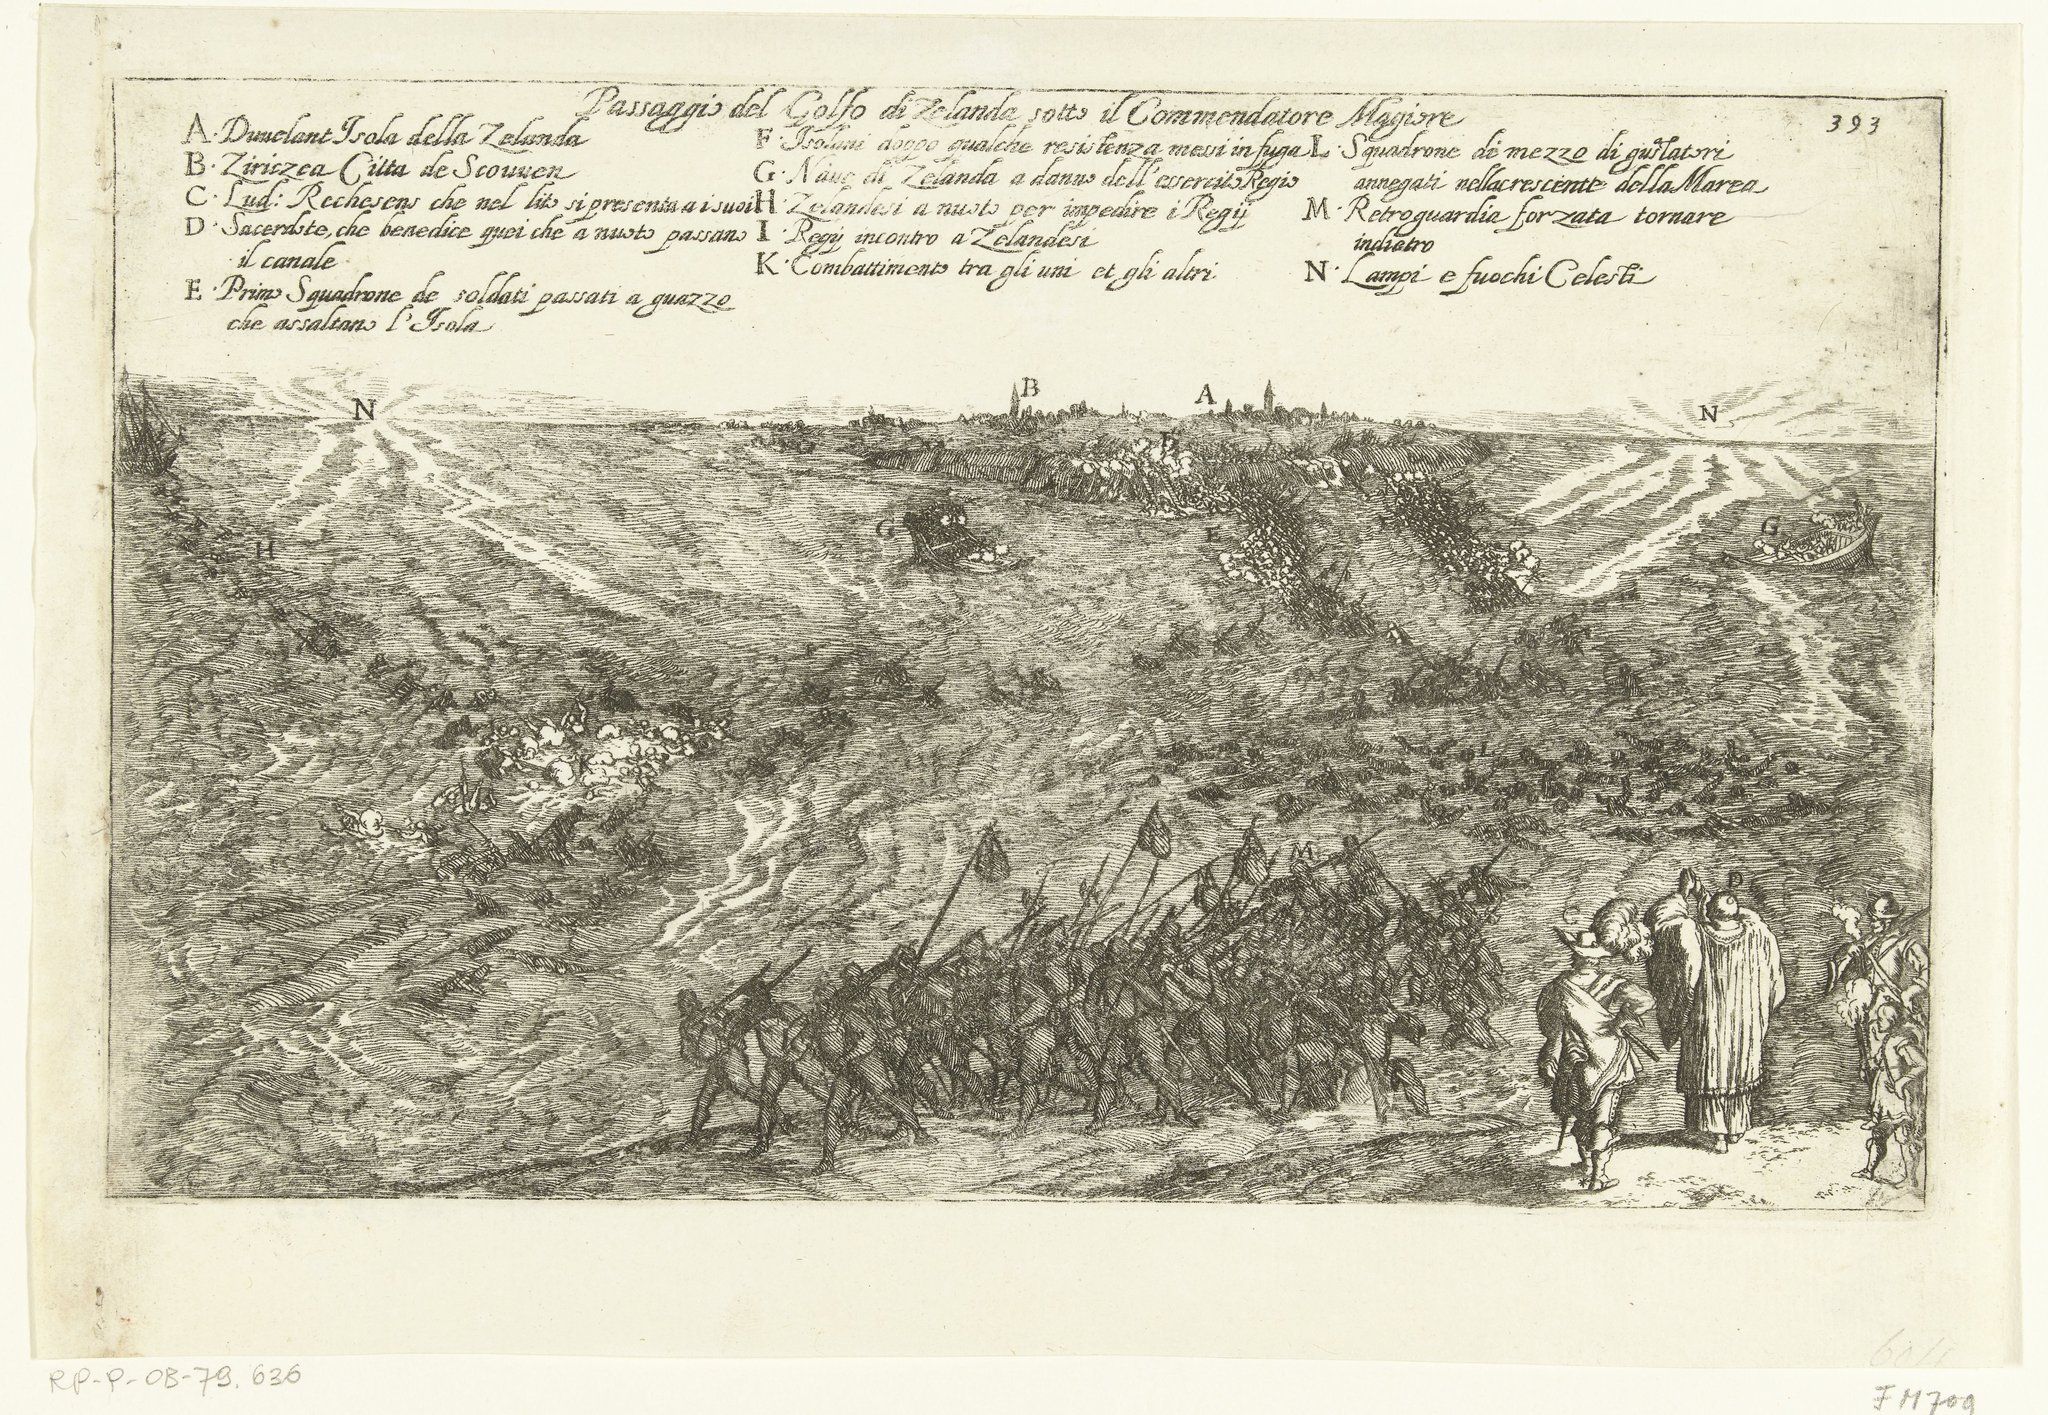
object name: history print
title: Passaggio del Golfo di Zelanda sotto il Commendatore Magiore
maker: Anonymous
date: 1630-1699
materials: paper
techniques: etching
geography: italy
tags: brussels, mayor, luis de zúñiga y requesens, army 'en route'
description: Nachtelijk tocht van Spaanse soldaten van Sint-Philipsland door het water naar het eiland Duiveland, 28 september 1575. Op de voorgrond op Tholen zegent een jezuïet de vertrekkende soldaten, in de verte het eiland Duivenland en Zierikzee. Bovenaan de legenda A-N in het Italiaans.